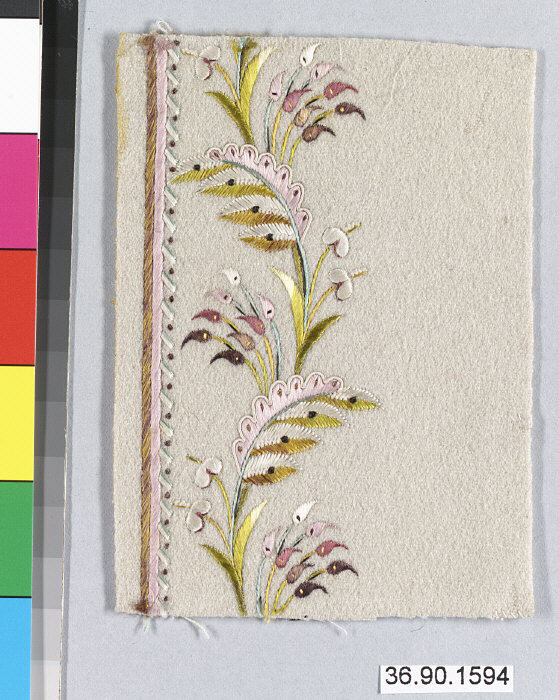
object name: sample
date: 1801-1833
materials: felt, silk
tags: plants